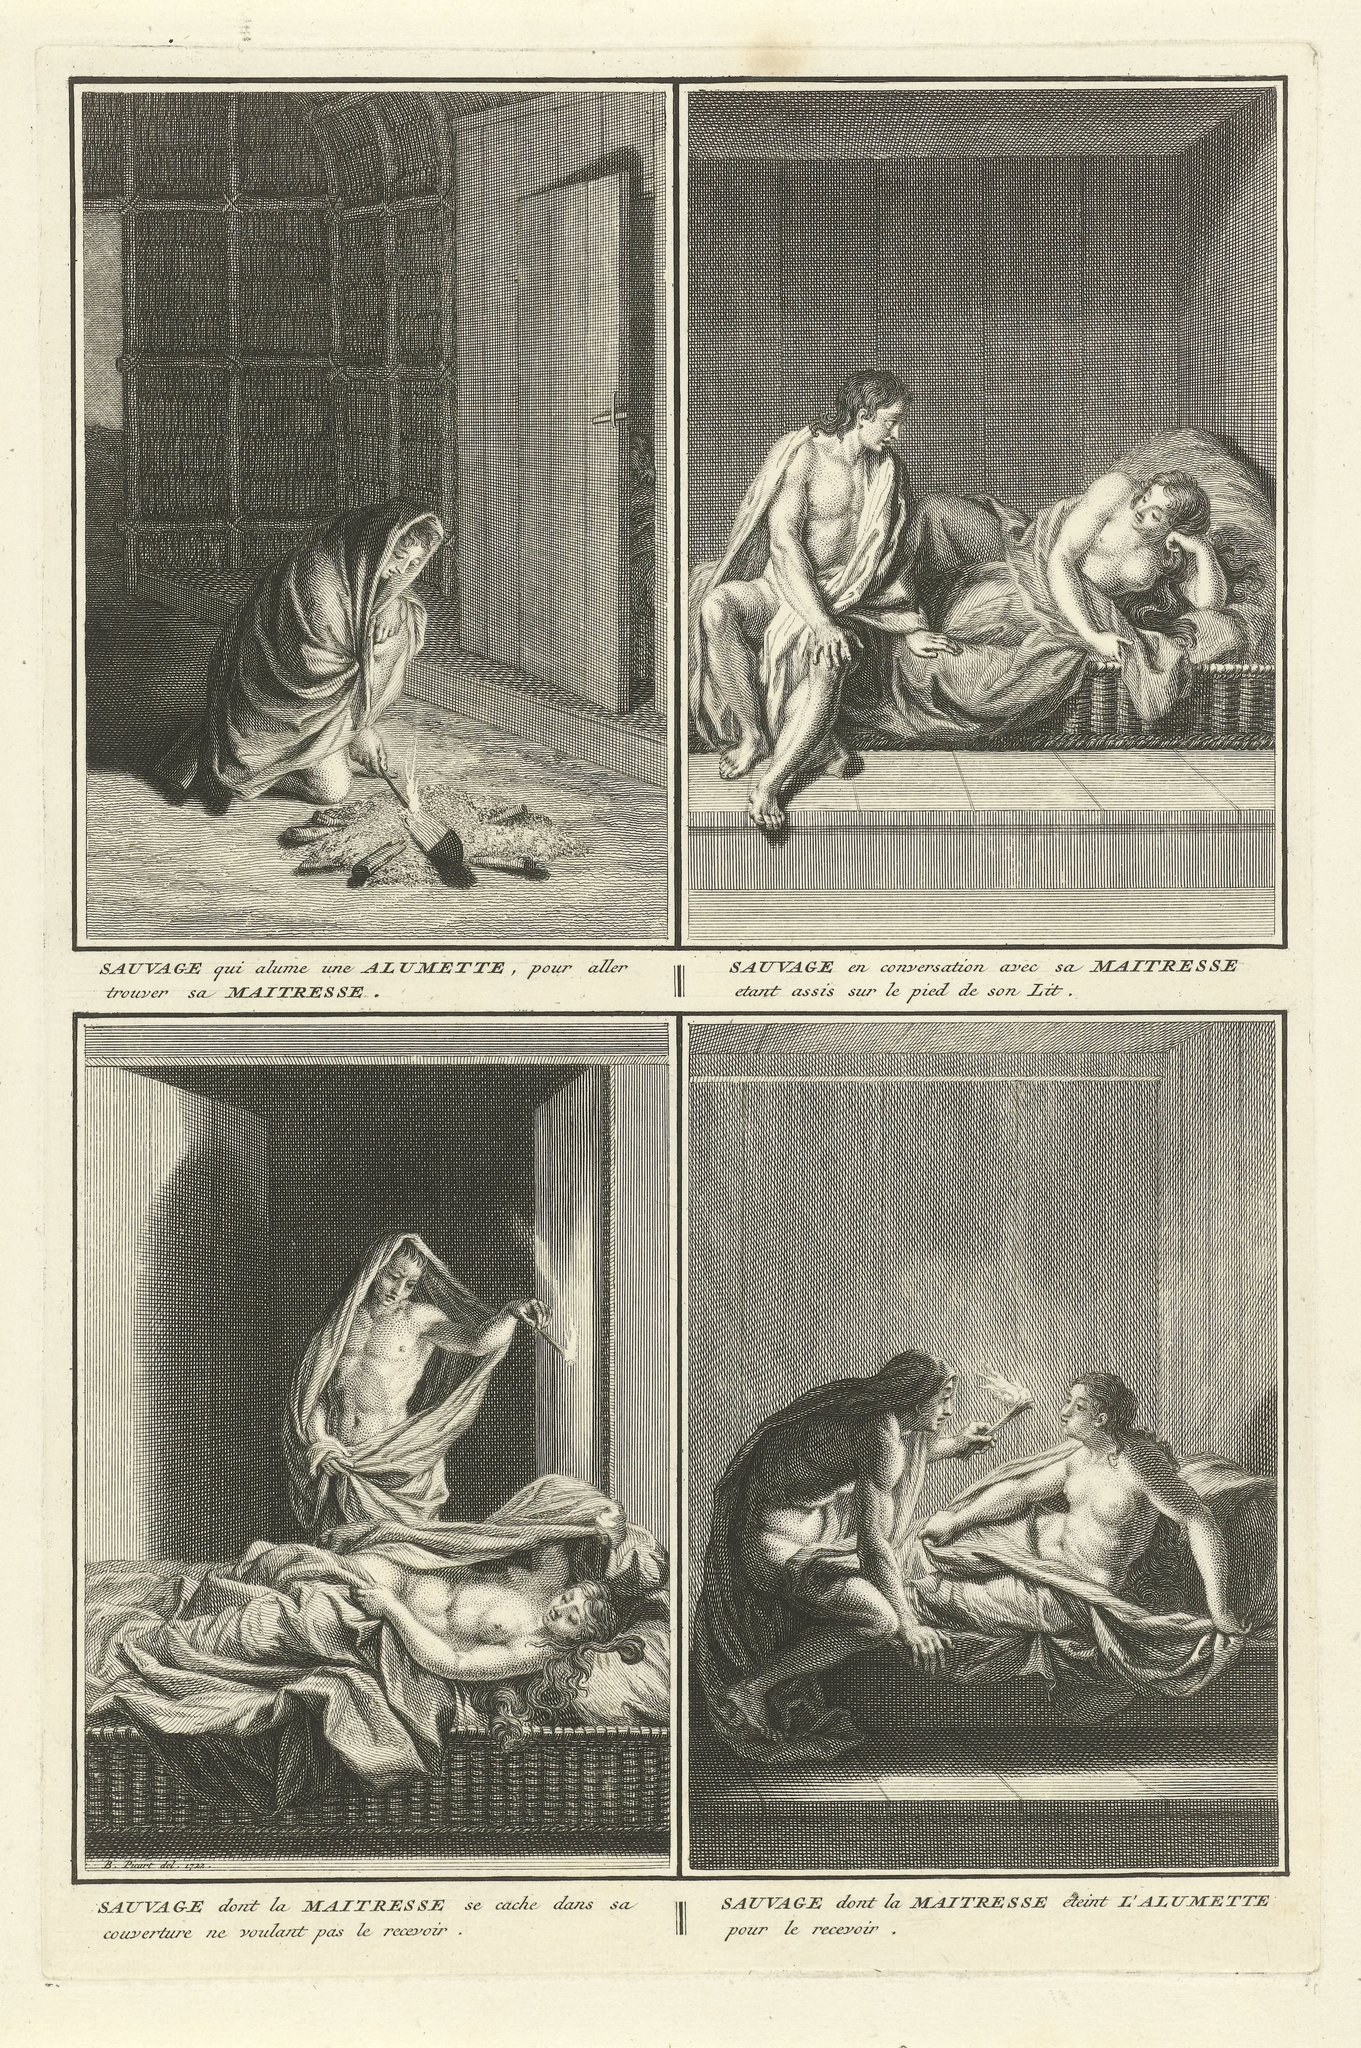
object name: book illustration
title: Liefdesrituelen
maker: bernard picart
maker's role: draughtsman, print maker, publisher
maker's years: 1673-1733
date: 1722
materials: paper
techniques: engraving, etching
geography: amsterdam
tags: torch, bed, lovers; courting, flirting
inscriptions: collector's mark: Lugt 2228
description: Prent waarschijnlijk ook gebruikt in: Picart, Bernard. Naaukeurige beschryving der uitwendige godtsdienst-plichten, kerk-zeden en gewoontens van alle volkeren der waereldt. [Vertaald in het Nederlands door] Moubach, Abraham. Den Haag, Amsterdam, Rotterdam: Rutgert Alberts, Hermannus Uytwerf, Jan Daniel Beman, Isaac van der Kloot, 1727-1738. Prent ook gebruikt als illustratie in: Picart, Bernard. Cérémonies et coutumes religieuses de tous les peuples du monde: représentées par des figures, deel III. Amsterdam: Jean Frédéric Bernard, 1723-1743.